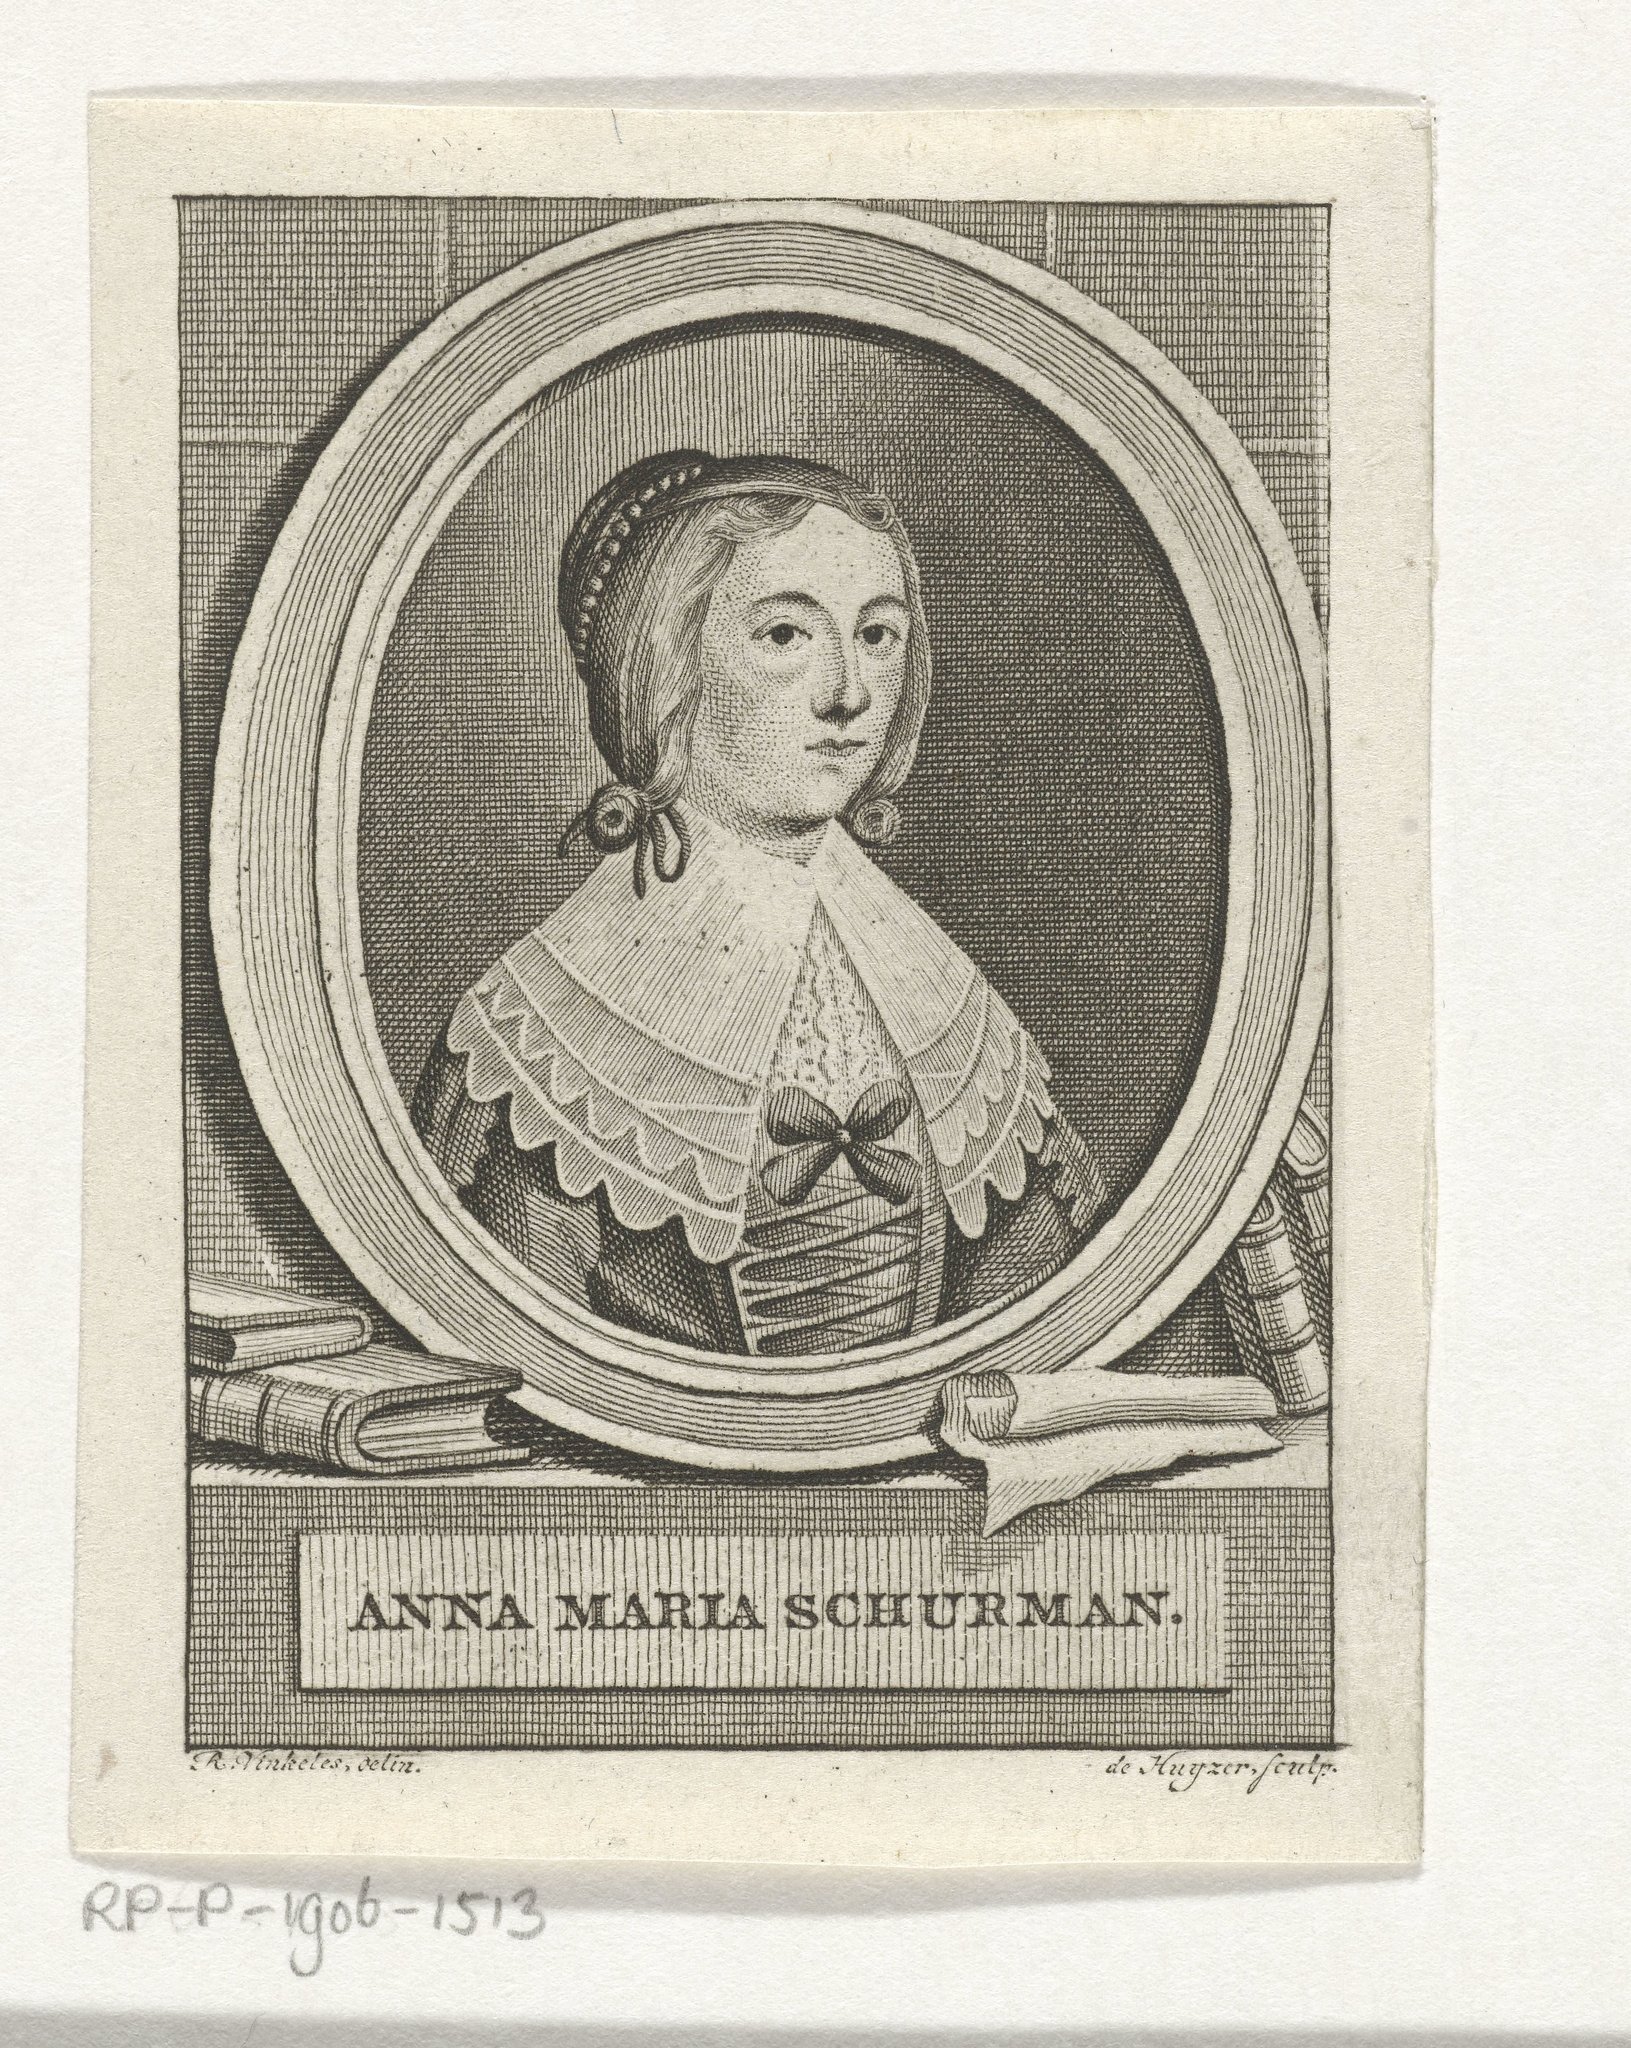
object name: print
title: Portret van Anna Maria van Schurman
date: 1763-1804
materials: paper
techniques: engraving, etching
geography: amsterdam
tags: cologne, print maker, draughtsman, anna maria van schurman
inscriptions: collector's mark: Lugt 2228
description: Buste van Anna Maria van Schurman, geleerde, dichteres en kunstenares, naar rechts in ovale lijst. Onderaan voor de lijst enkele boeken.